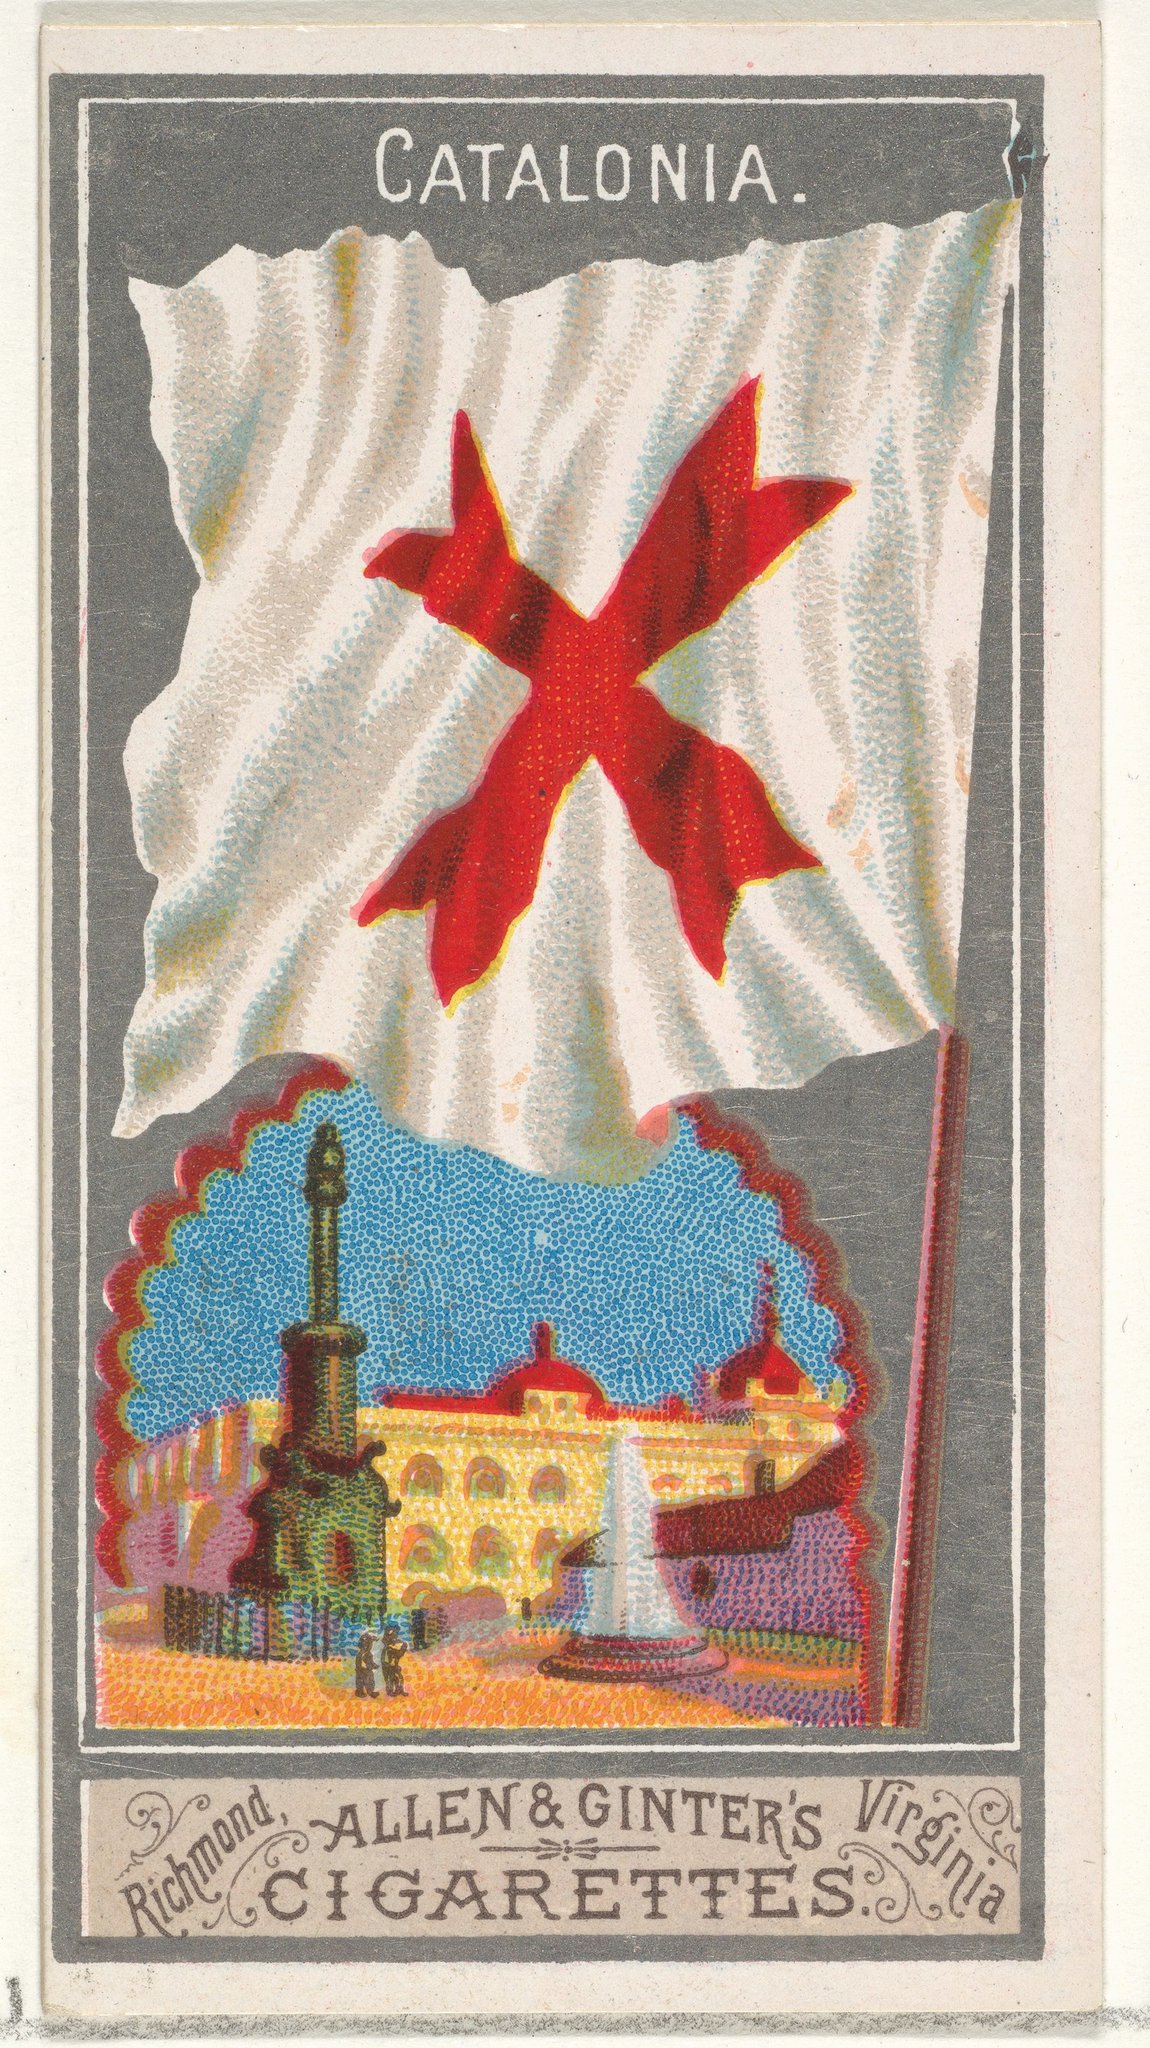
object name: print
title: Catalonia, from the City Flags series (N6) for Allen & Ginter Cigarettes Brands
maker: allen & ginter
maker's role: publisher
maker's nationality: american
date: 1887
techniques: color lithograph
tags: flags